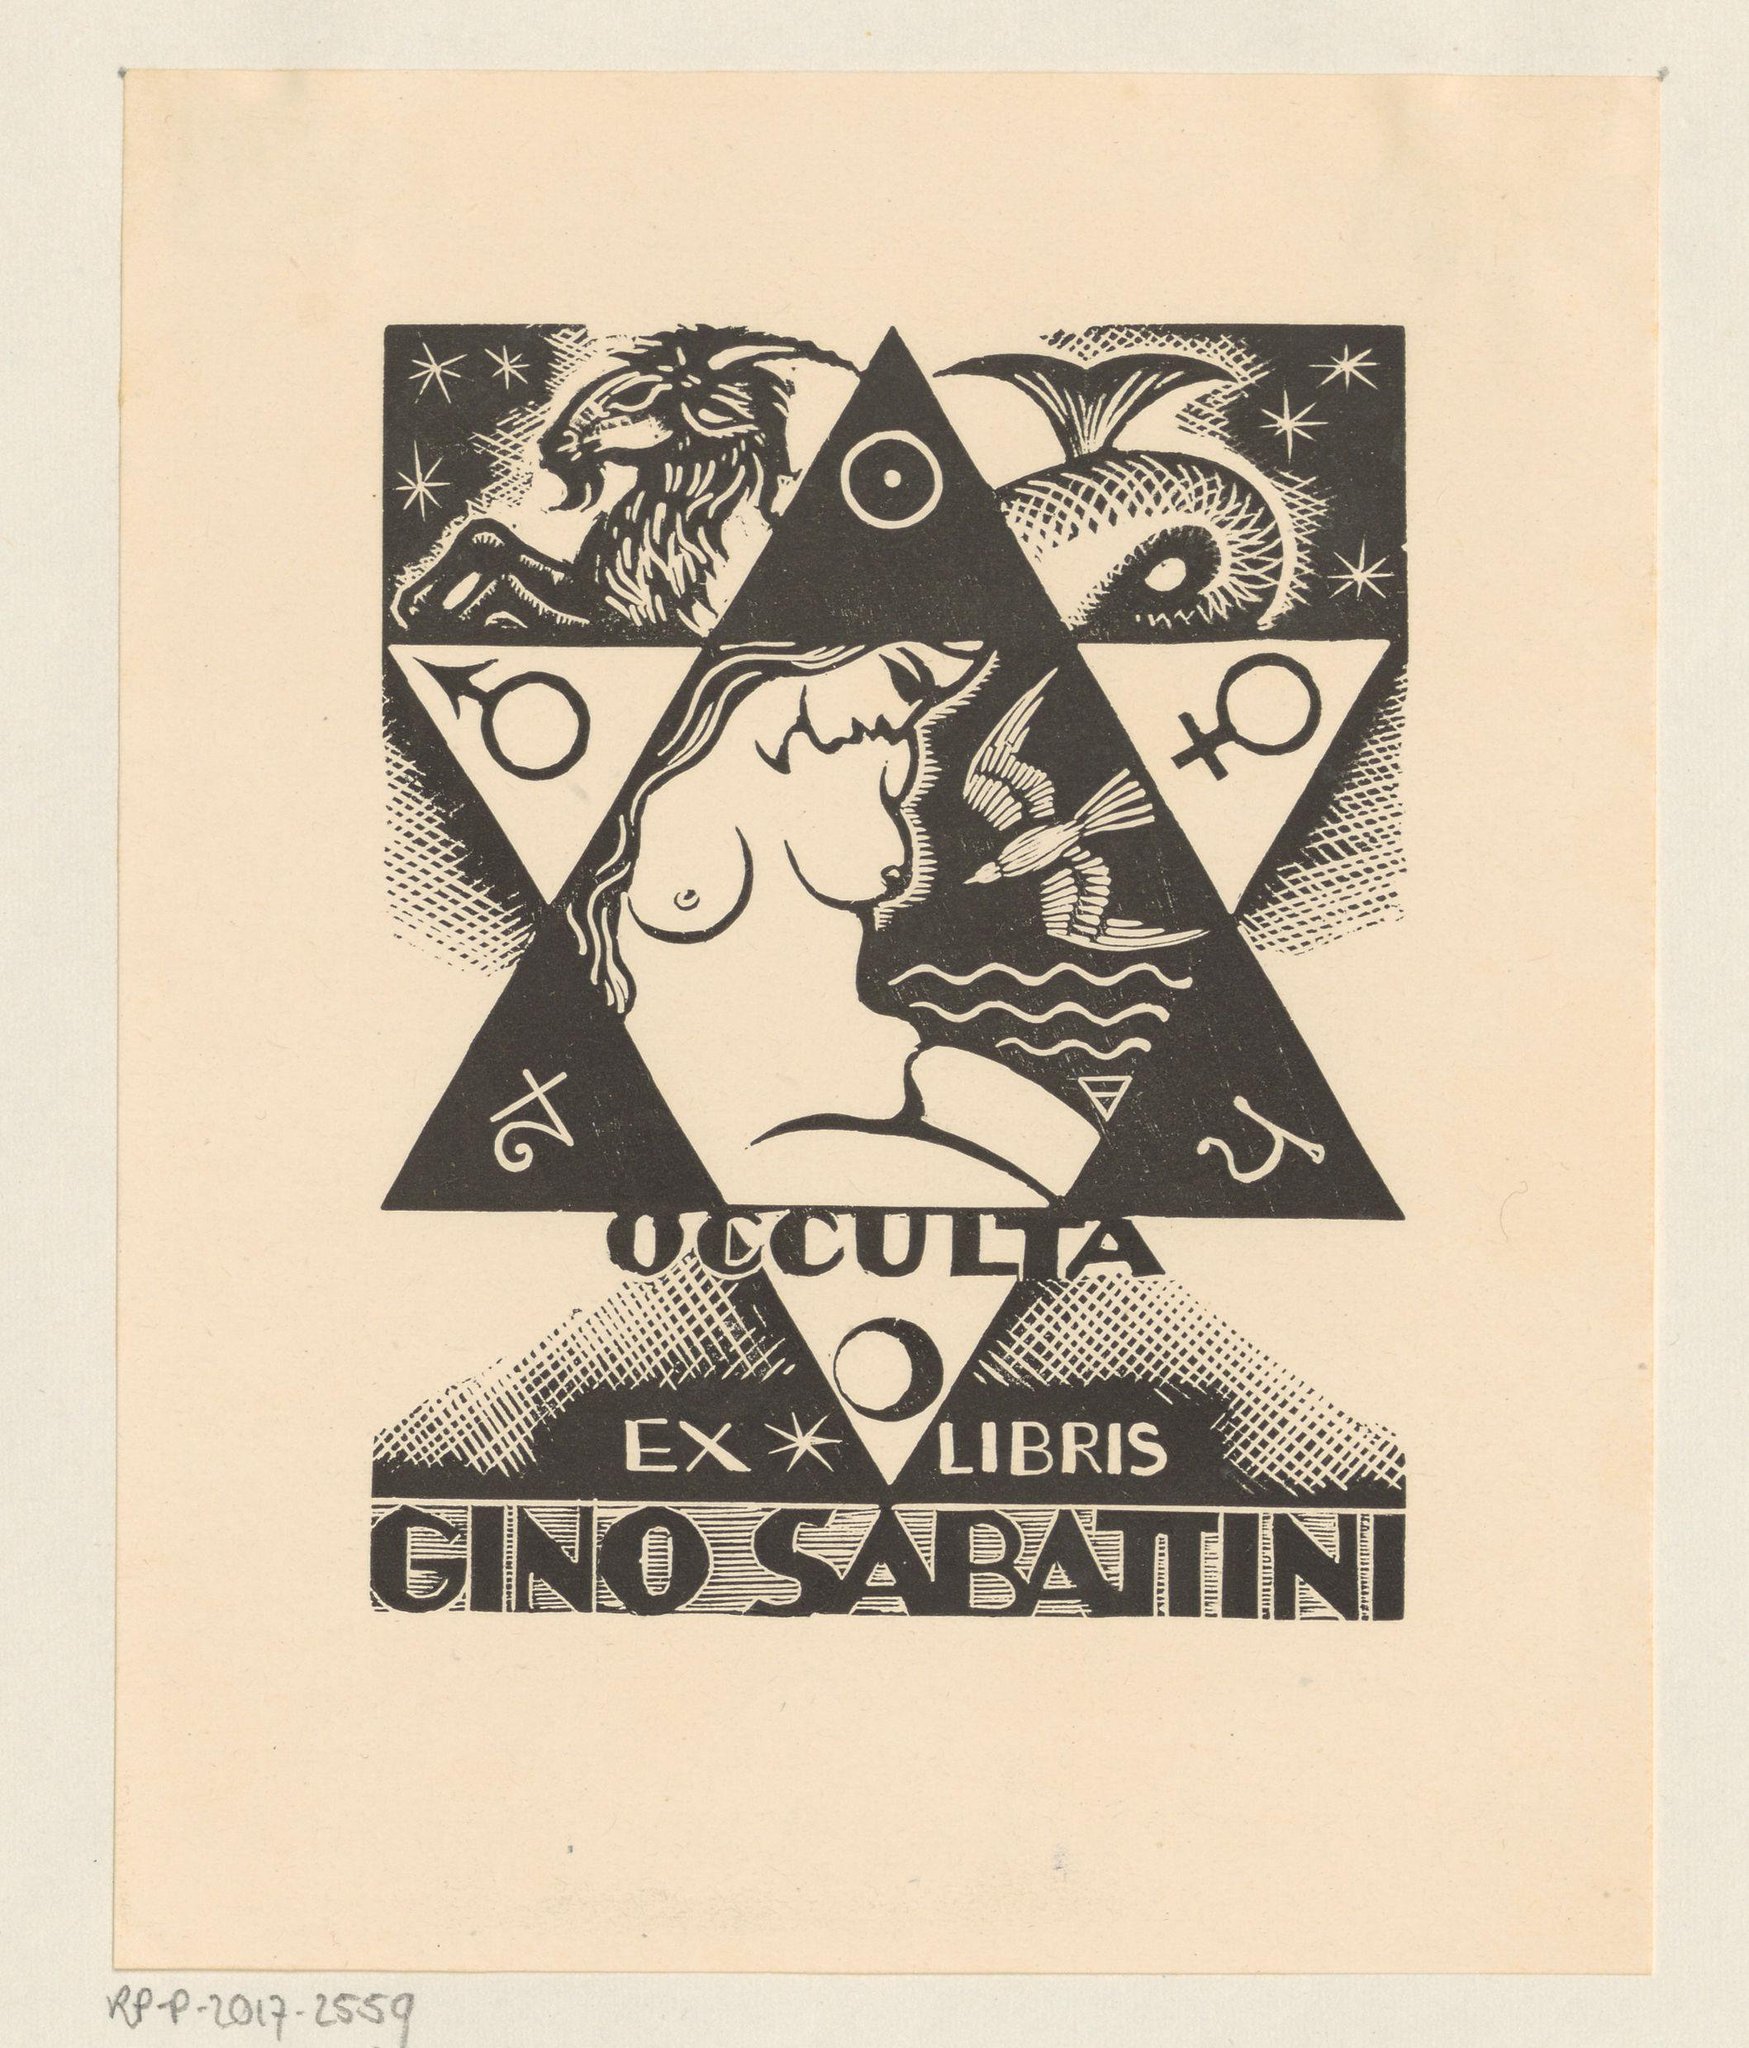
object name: bookplate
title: Ex libris van Gino Sabattini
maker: cesare vincenti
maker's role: print maker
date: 1940-1960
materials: paper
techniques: woodcut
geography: italy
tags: gino sabattini, woman (showing herself) undressed, quasi-nude, zodiac; the twelve zodiacal signs together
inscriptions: inscription: ‘C. Vincenti’